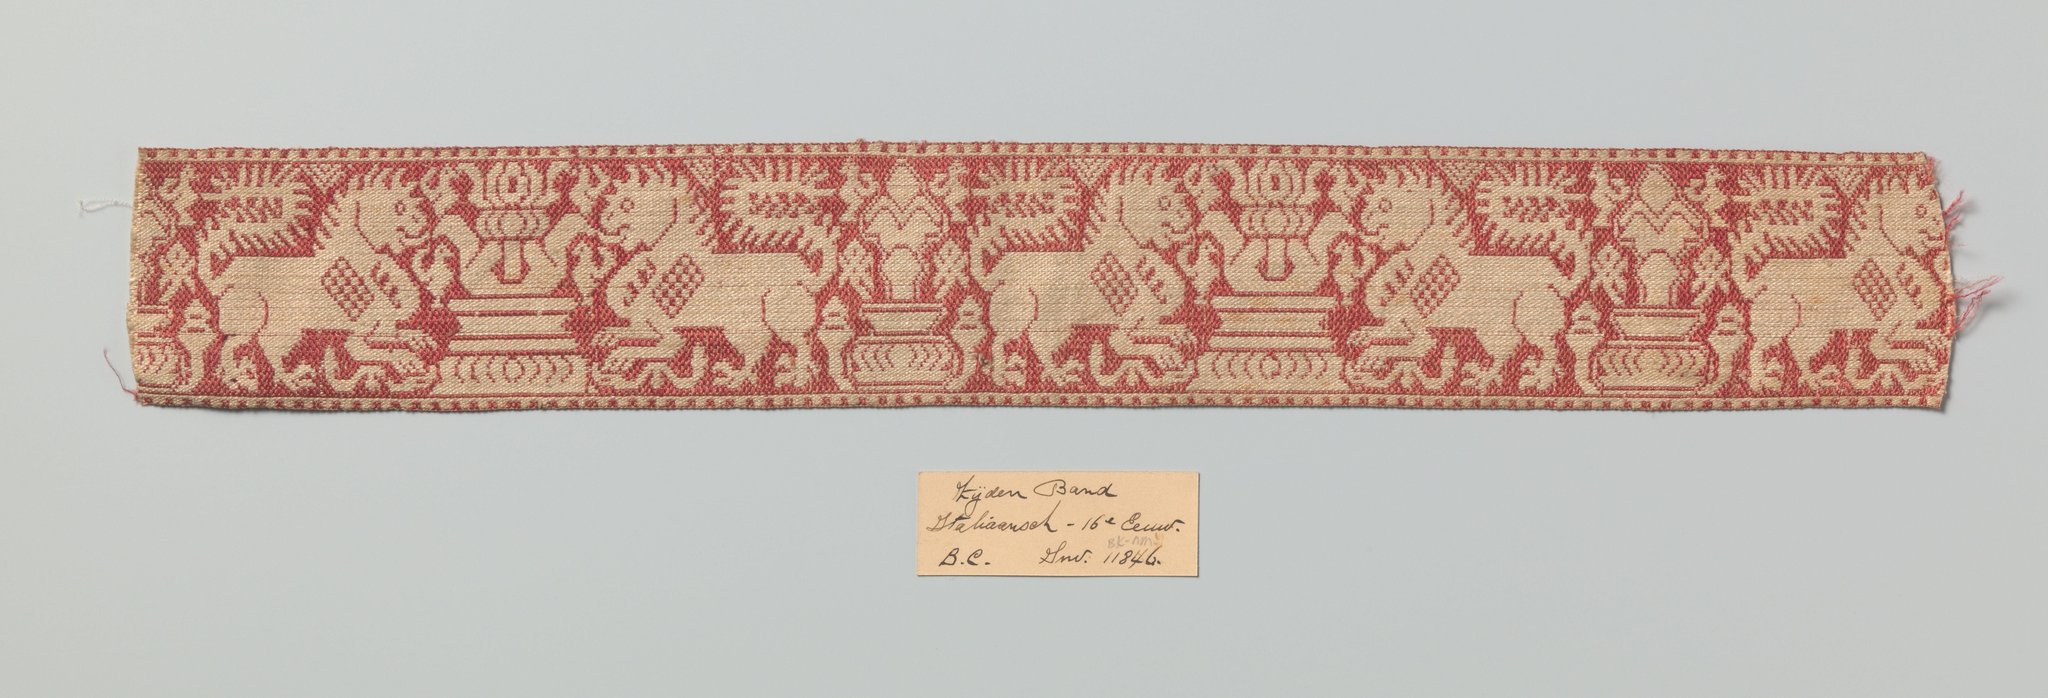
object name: silk textile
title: Weefsel van zijde met een doorlopend patroon van symmetrische leeuwen, ter weerszijden van een standaard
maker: Anonymous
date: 1500-1599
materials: silk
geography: italy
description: Weefsel van zijde. Rand. Op een witte grond tekent een rode inslag het doorlopend patroon van symemtrische leeuwen, ter weerszijden van een standaard. Kleine duiven of haantjes, benevens de gestileerde leeuwenstaarten vullen de overige ruimte. Italië.